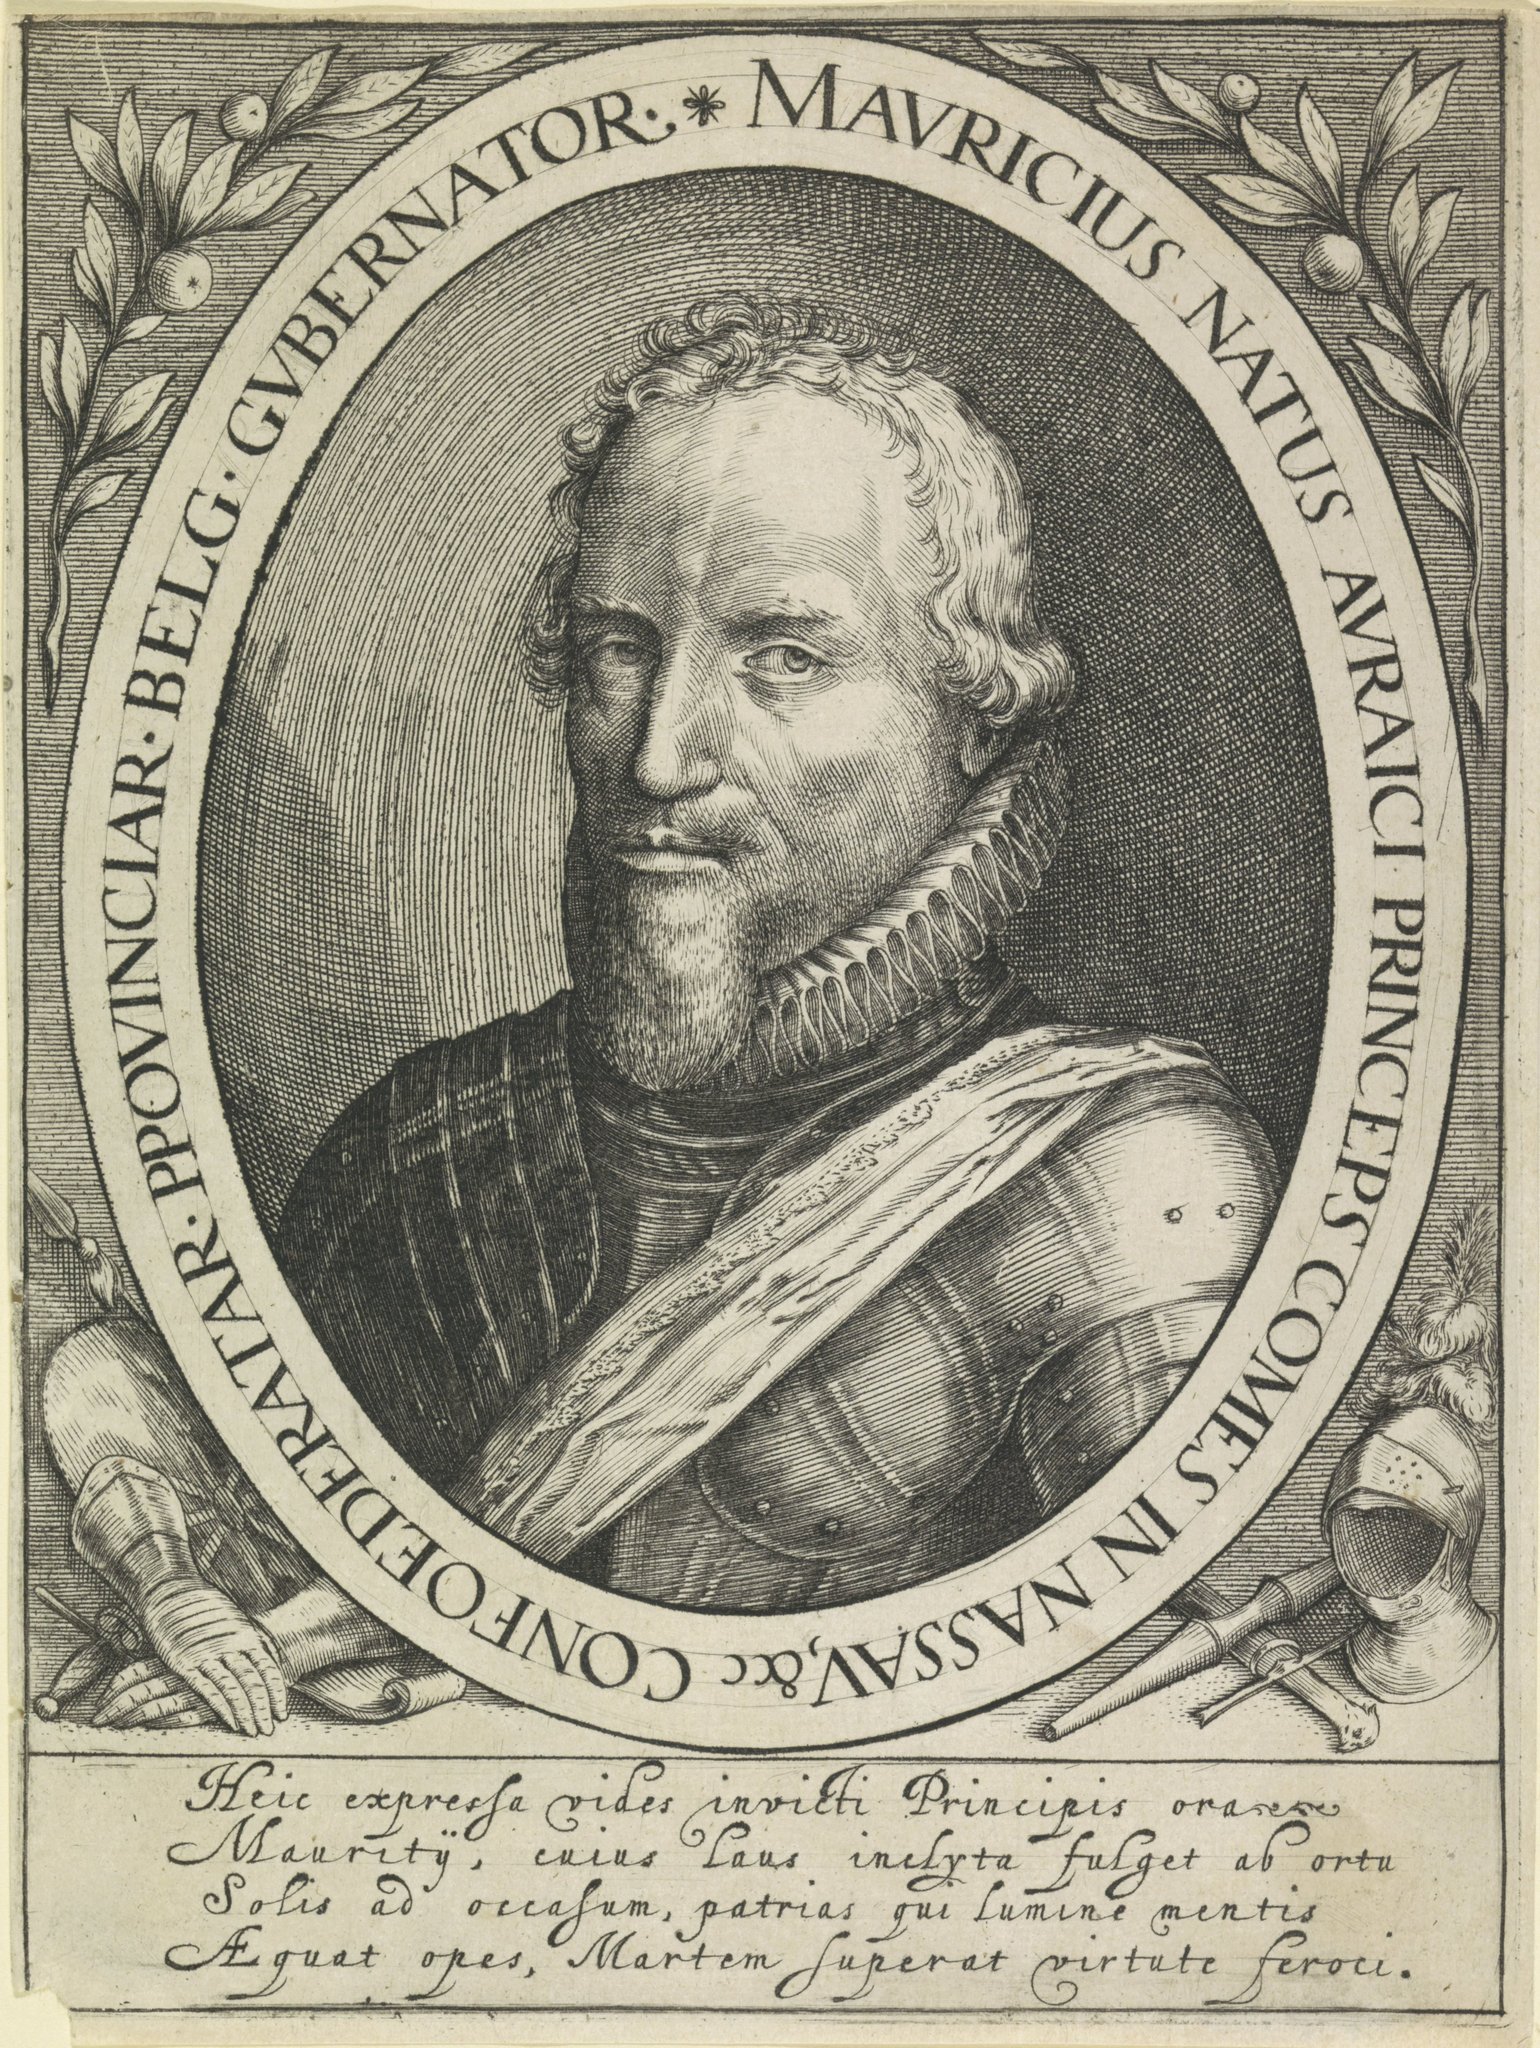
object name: print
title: Portret van Maurits, prins van Oranje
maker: Anonymous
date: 1600-1699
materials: paper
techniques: engraving, etching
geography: low countries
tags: maurice (prince of orange)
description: De hier vermelde titel verwijst naar de hoogst verkregen titel van de geportretteerde, niet per se naar de titel die de geportretteerde op deze voorstelling draagt.